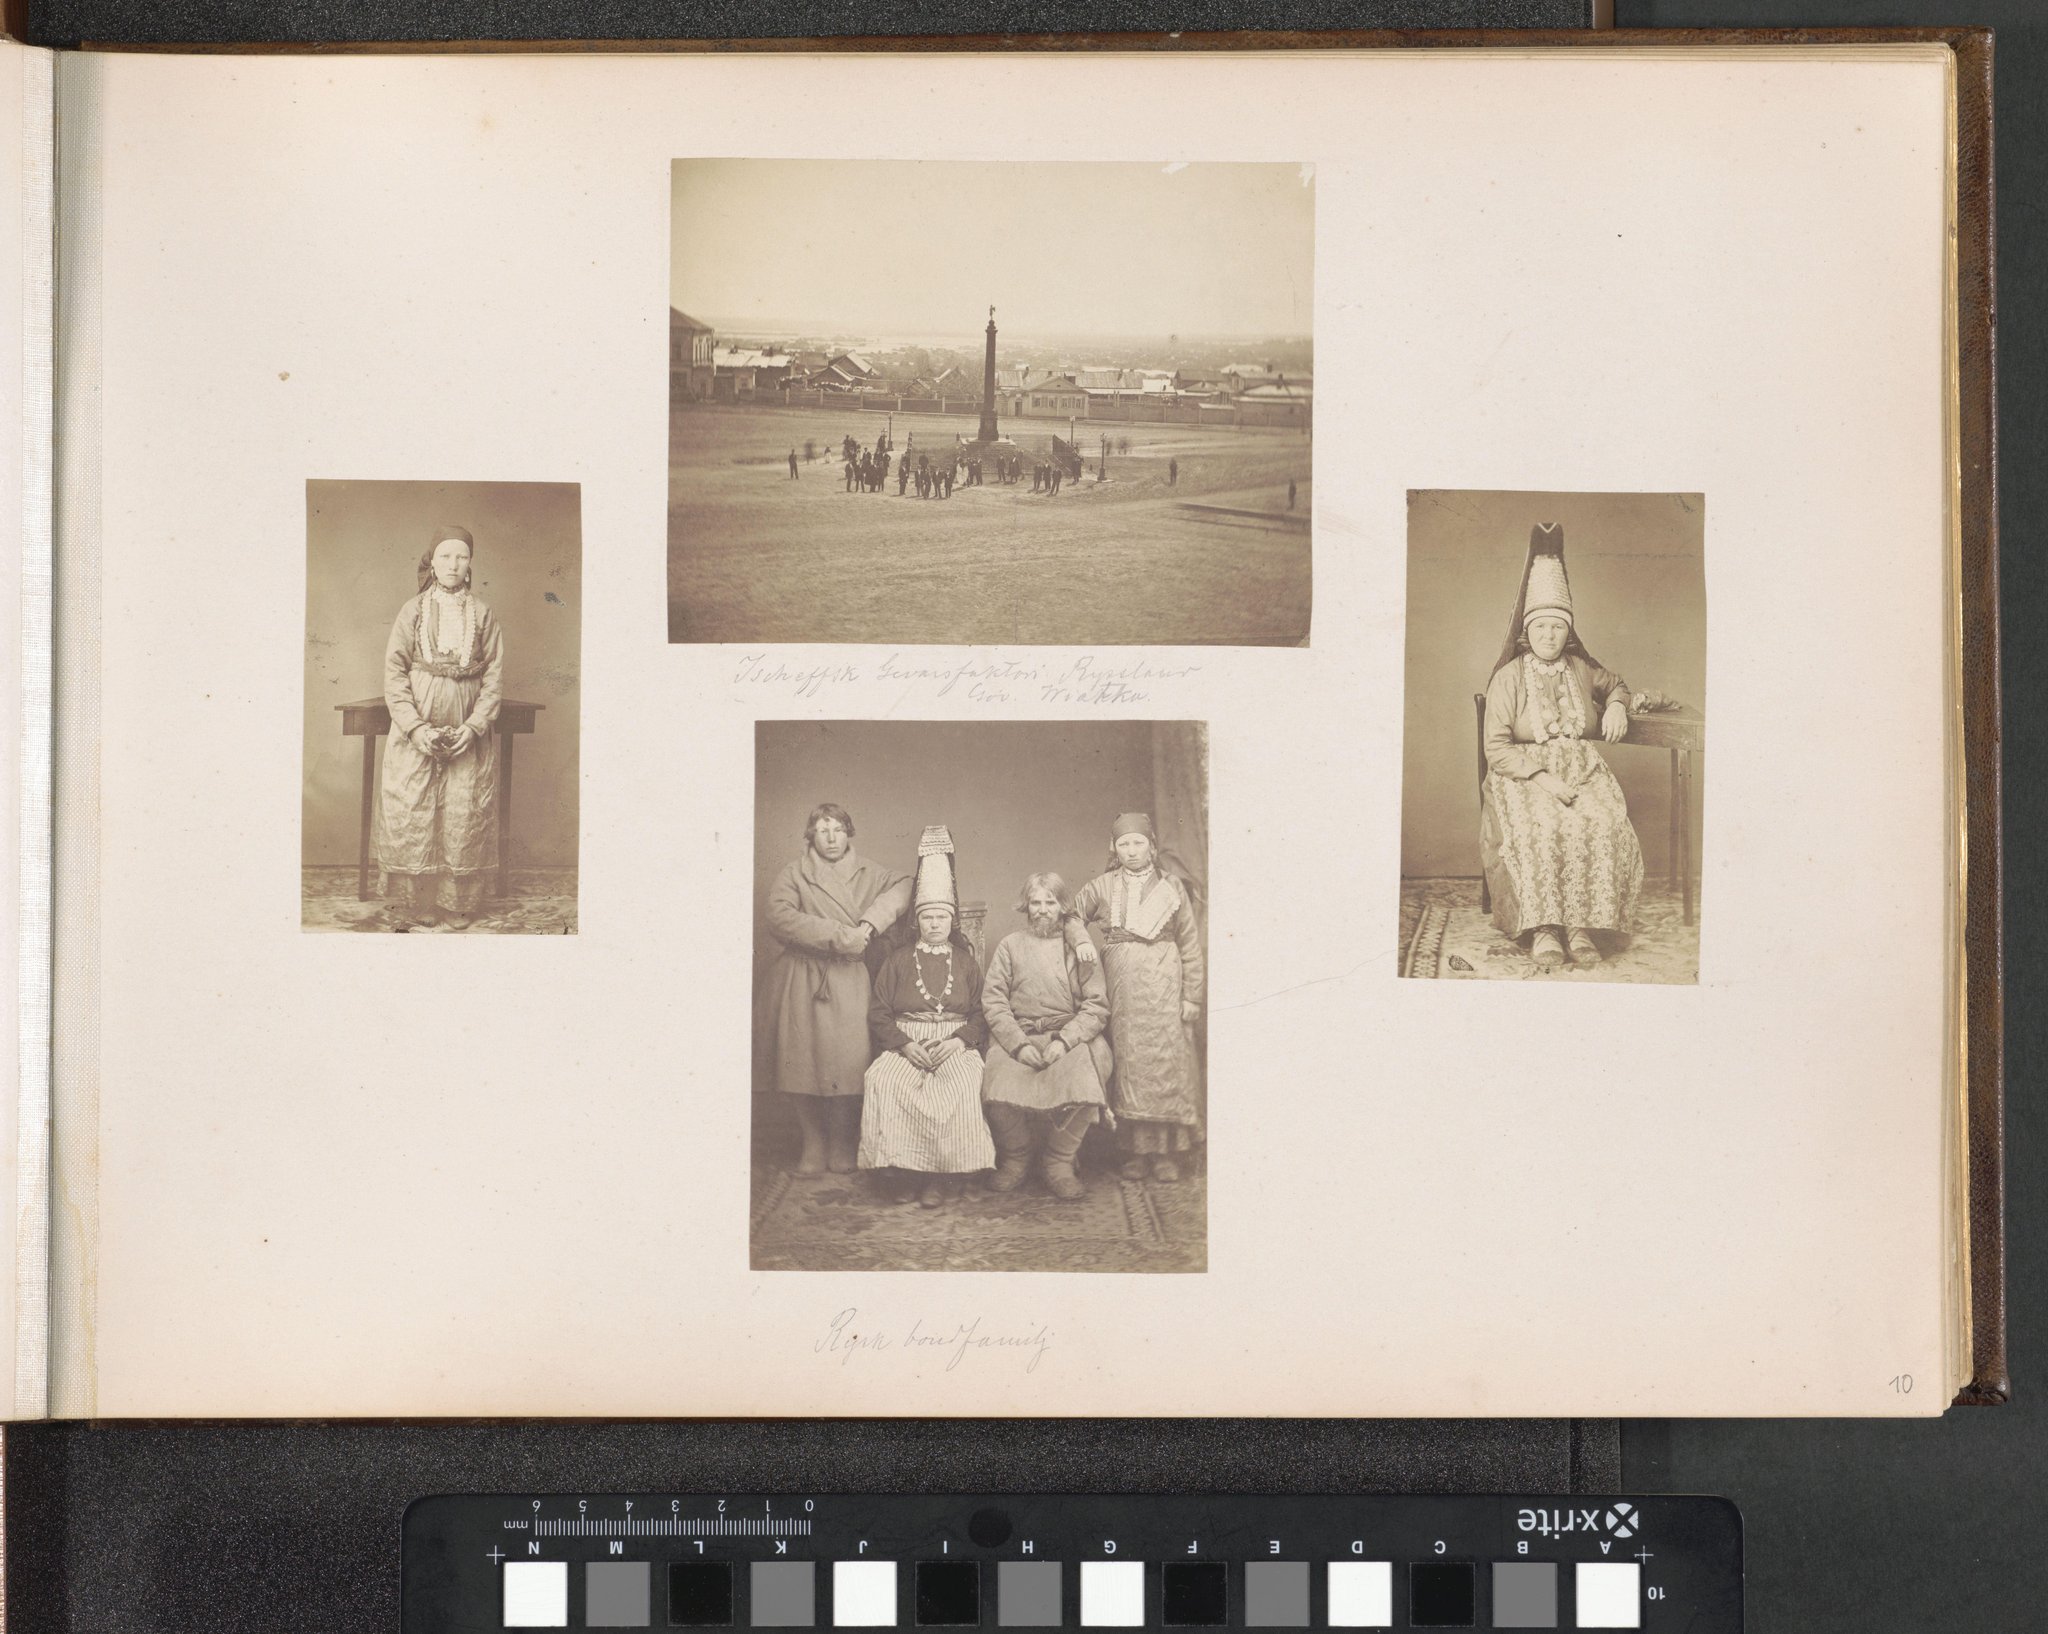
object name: photograph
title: Portret van een Russische vrouw met een lang gewaad, een hoofddeksel (kokoshnik) en sieraden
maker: Anonymous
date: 1878-1890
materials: photographic support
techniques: albumen print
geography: russia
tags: farmers - aa - female farmer, farmer's wife, russia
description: Onderdeel van Reisalbum Europese steden, vermoedelijk Zweeds.